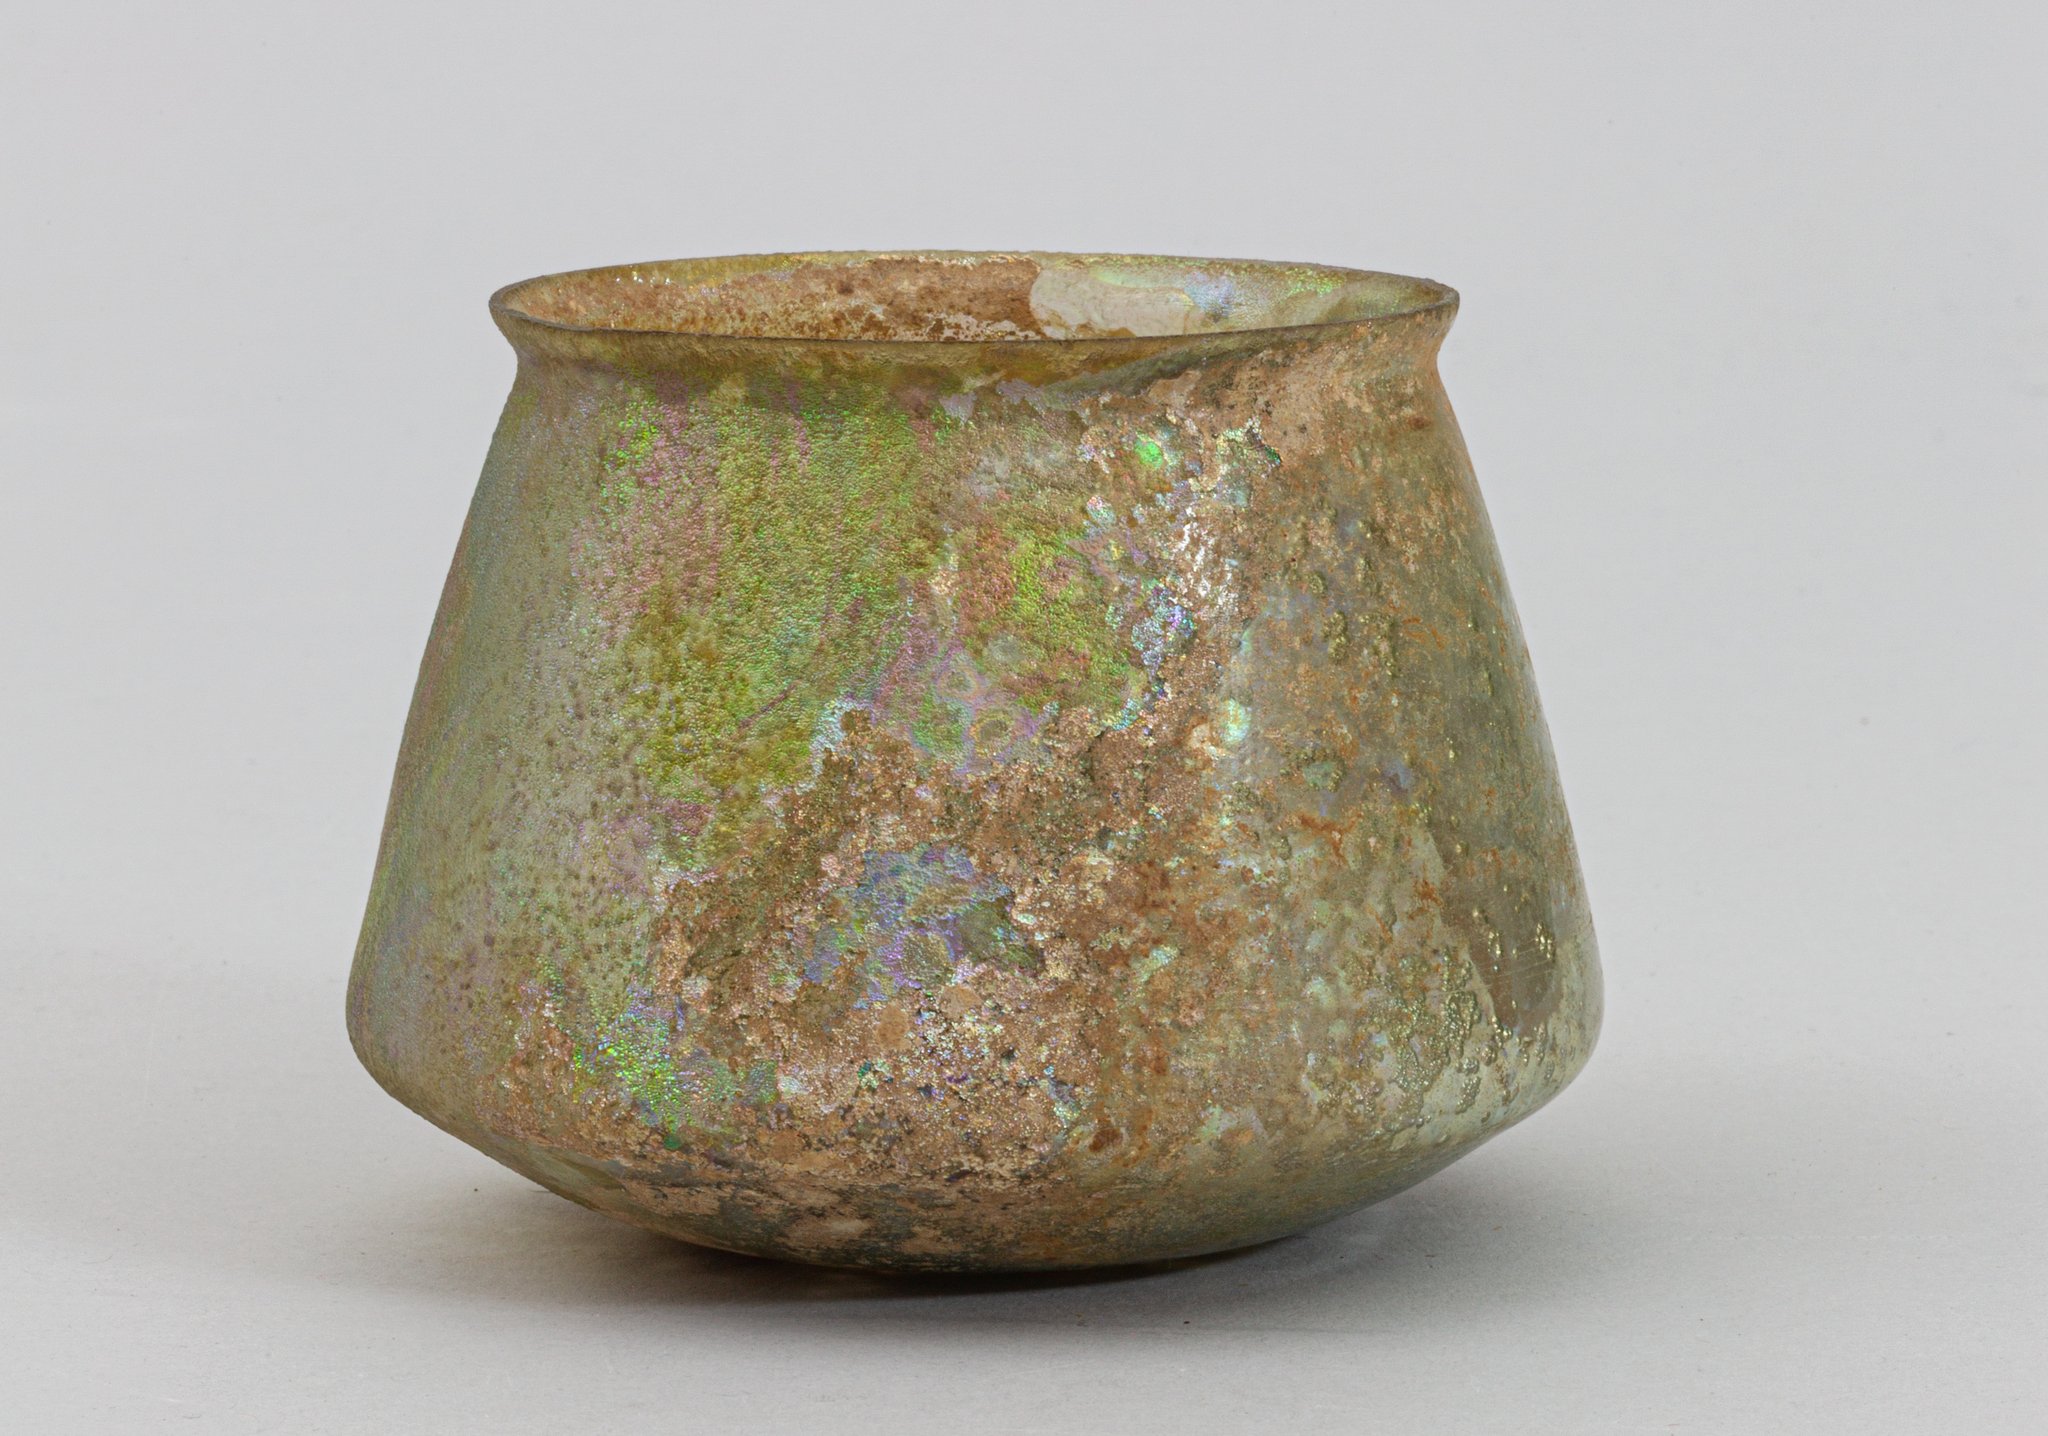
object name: bowl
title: Glass bowl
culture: roman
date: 201-300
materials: glass